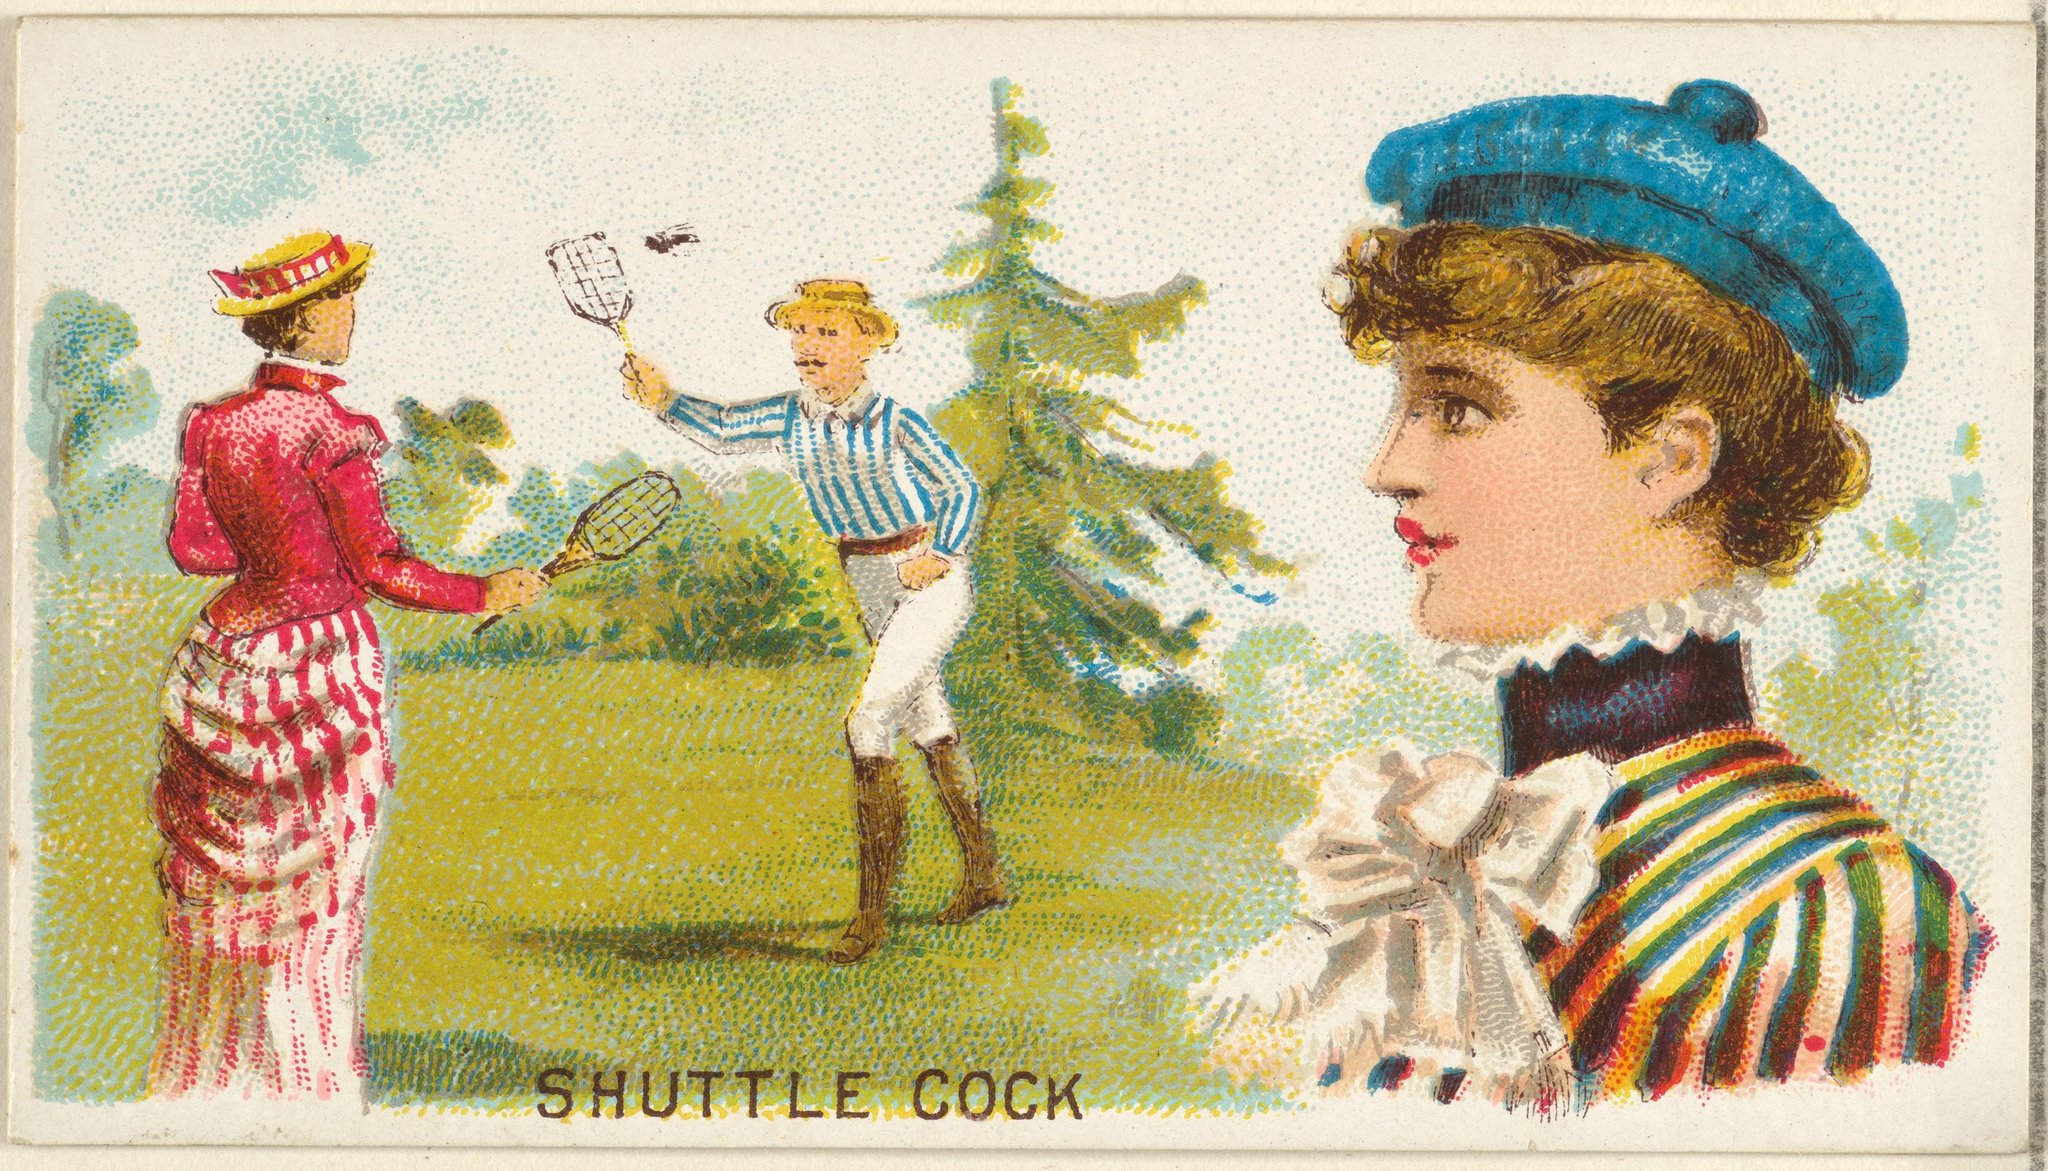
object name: print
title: Shuttlecock, from the Games and Sports series (N165) for Old Judge Cigarettes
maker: goodwin & company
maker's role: publisher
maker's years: 1850-1950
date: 1889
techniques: color lithograph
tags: men,women,games